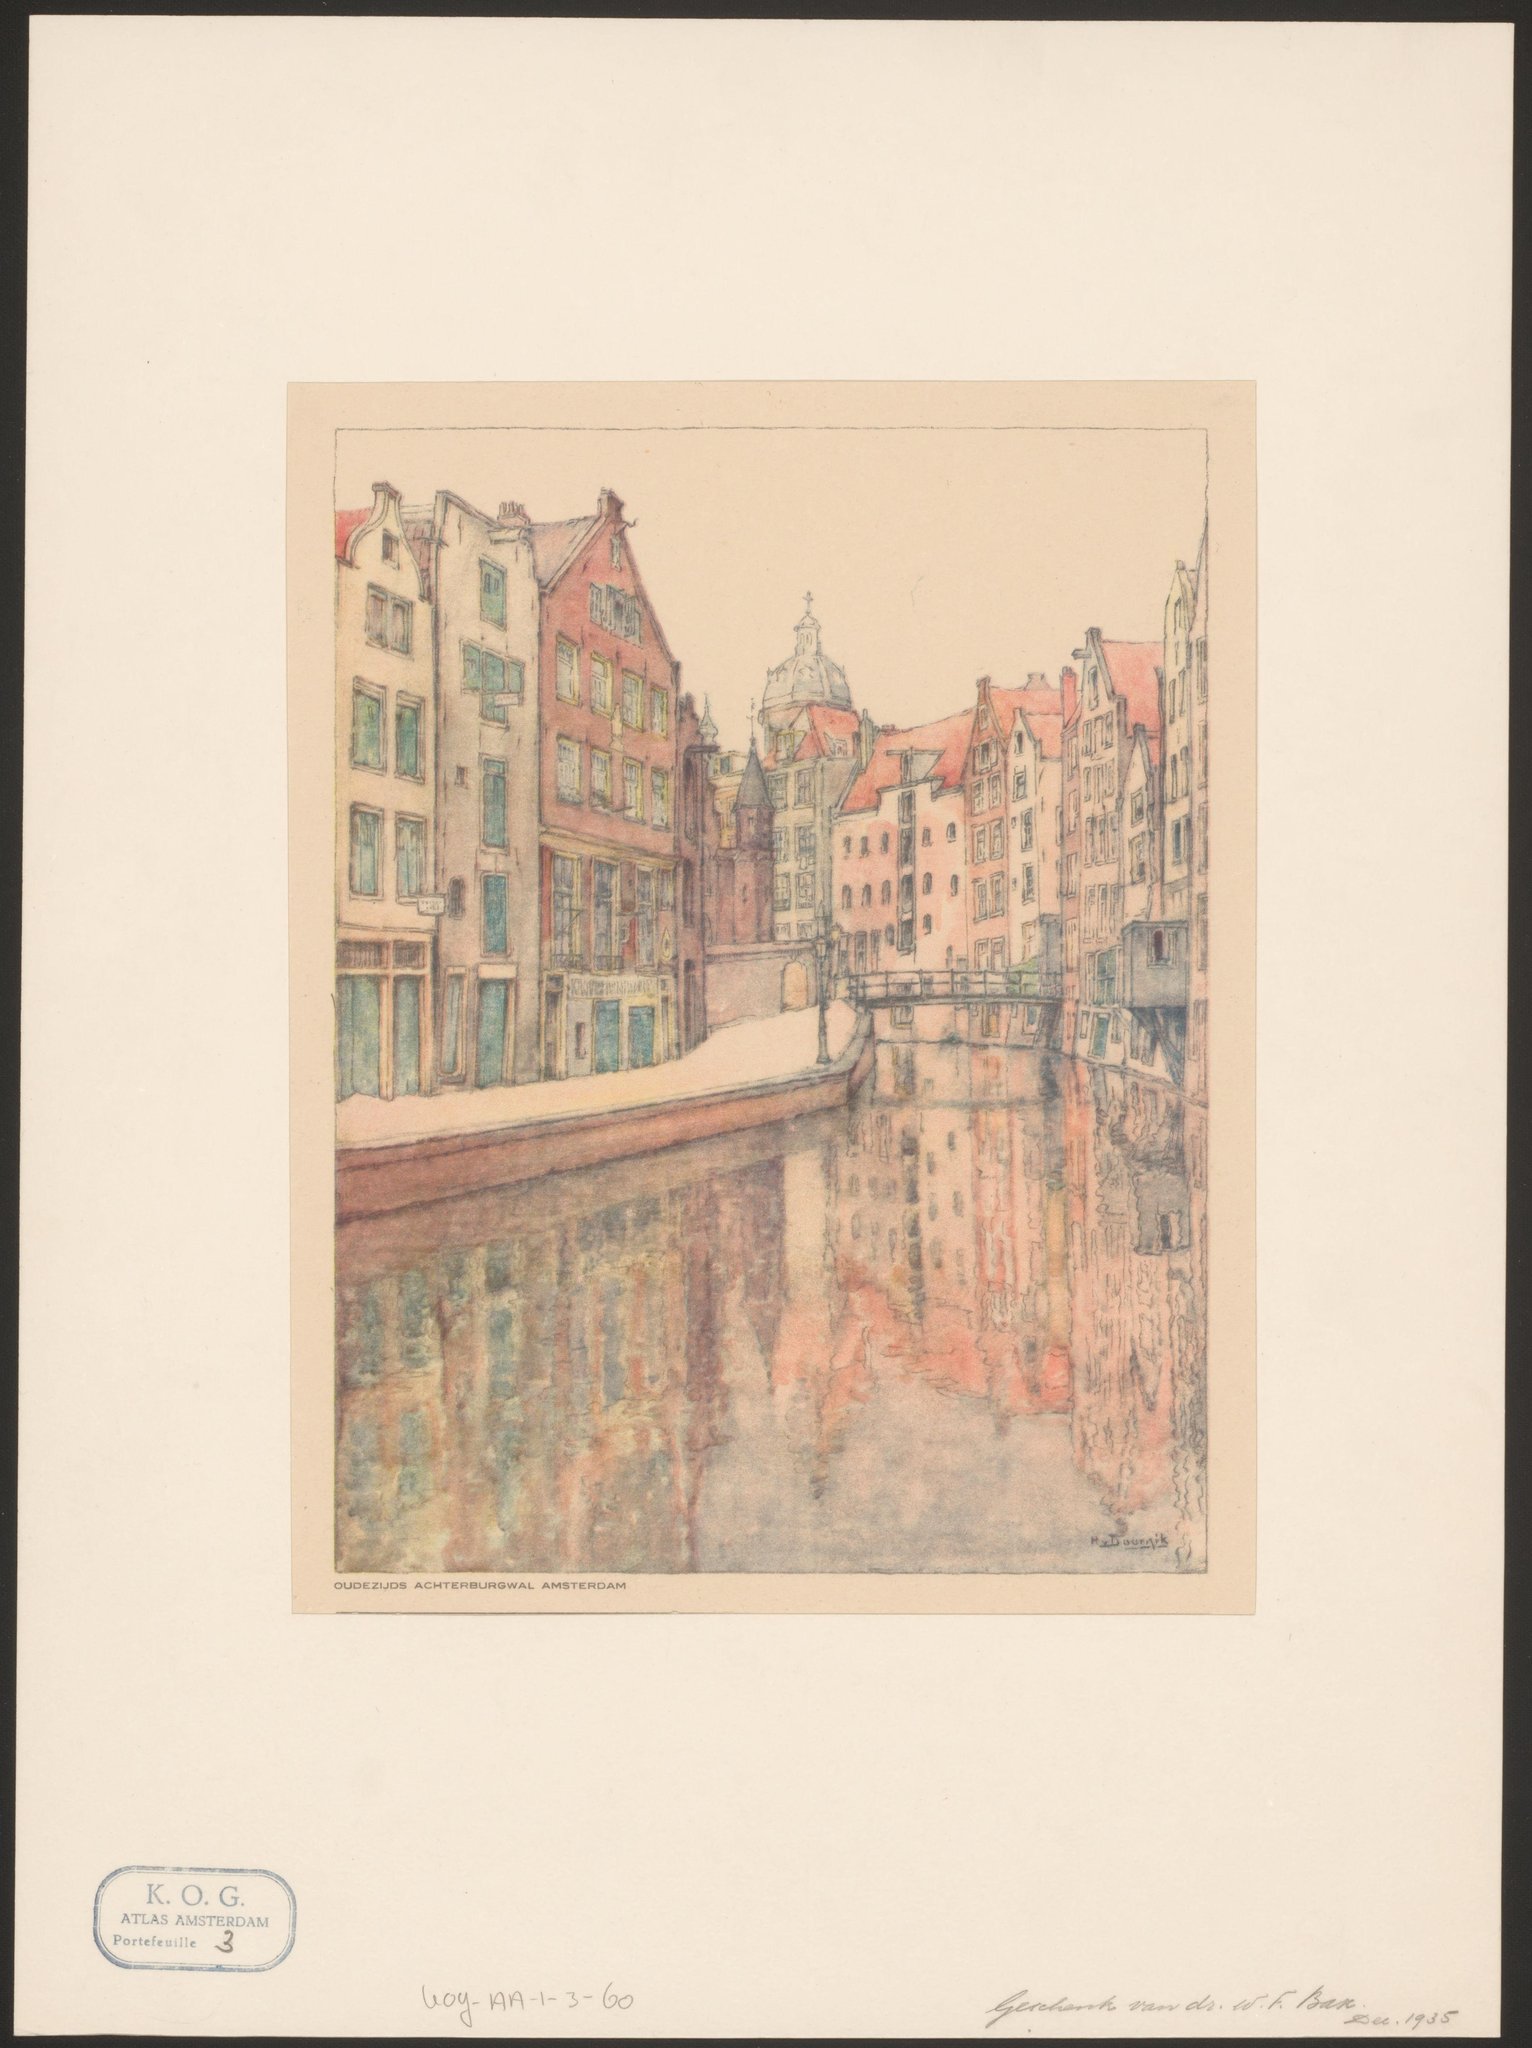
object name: photomechanical print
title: Gezicht op de Oudezijds Achterburgwal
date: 1890-1960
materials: paper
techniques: lithograph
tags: city-view in general; 'veduta', parts of church interior: dome, canal, the usual house or row of houses, bridge in city across river, canal, etc.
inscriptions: inscription: ‘Geschenk van dr. W.F. Bax (?) / Dec. 1935’, collector's mark: ‘3’ Lugt 1641b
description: Onderwerpsrubriek binnen de Atlas Amsterdam: Achterburgwal, Nieuwezijds en - Oudezijds; Nieuwe Achtergracht, Achterweg, Akoleienstraat.